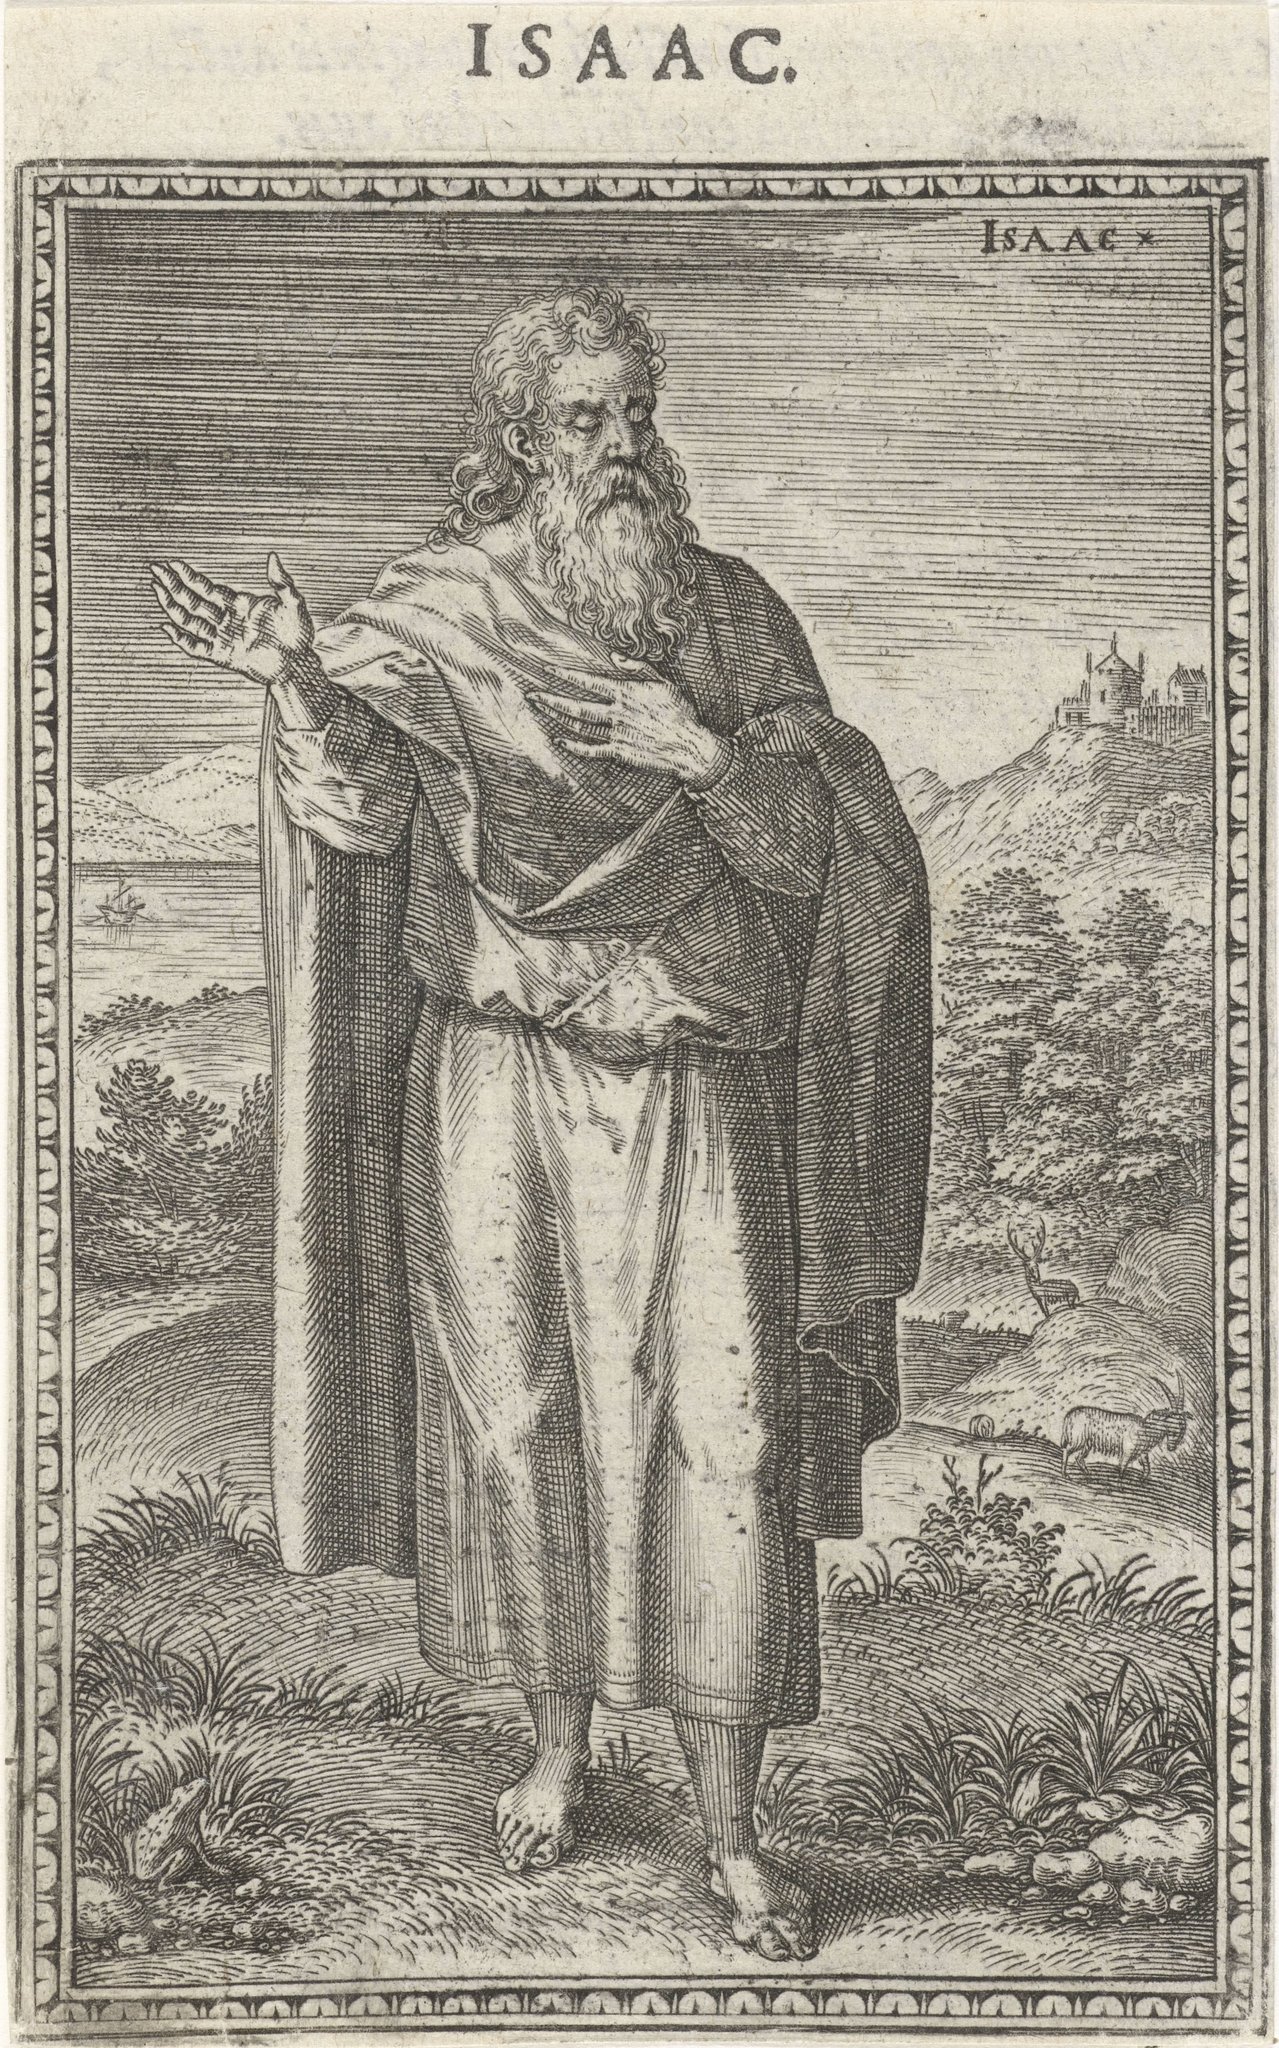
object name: print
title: Isaak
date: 1577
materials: paper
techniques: engraving, letterpress printing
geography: antwerp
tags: male persons from the old testament (with name) (not in biblical context)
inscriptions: collector's mark: Lugt 240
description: Boekillustratie voor Hillesem, Louis. Sacrarum antiquitatum monumenta. Antwerpen: Christoffel Plantin, 1577.